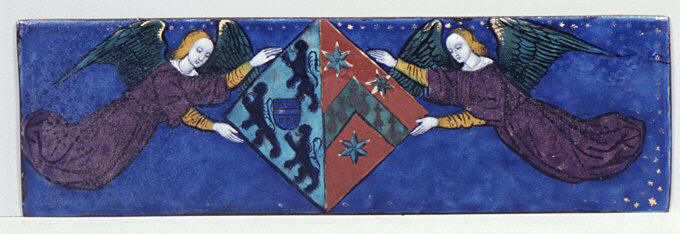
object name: panel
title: Angels presenting the arms of Halewyn impaling Van Ghistele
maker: nardon pénicaud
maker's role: enameler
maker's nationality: french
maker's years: 1470-1543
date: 1501-1525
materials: copper, enamel, gilt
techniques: painting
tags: angels,coat of arms